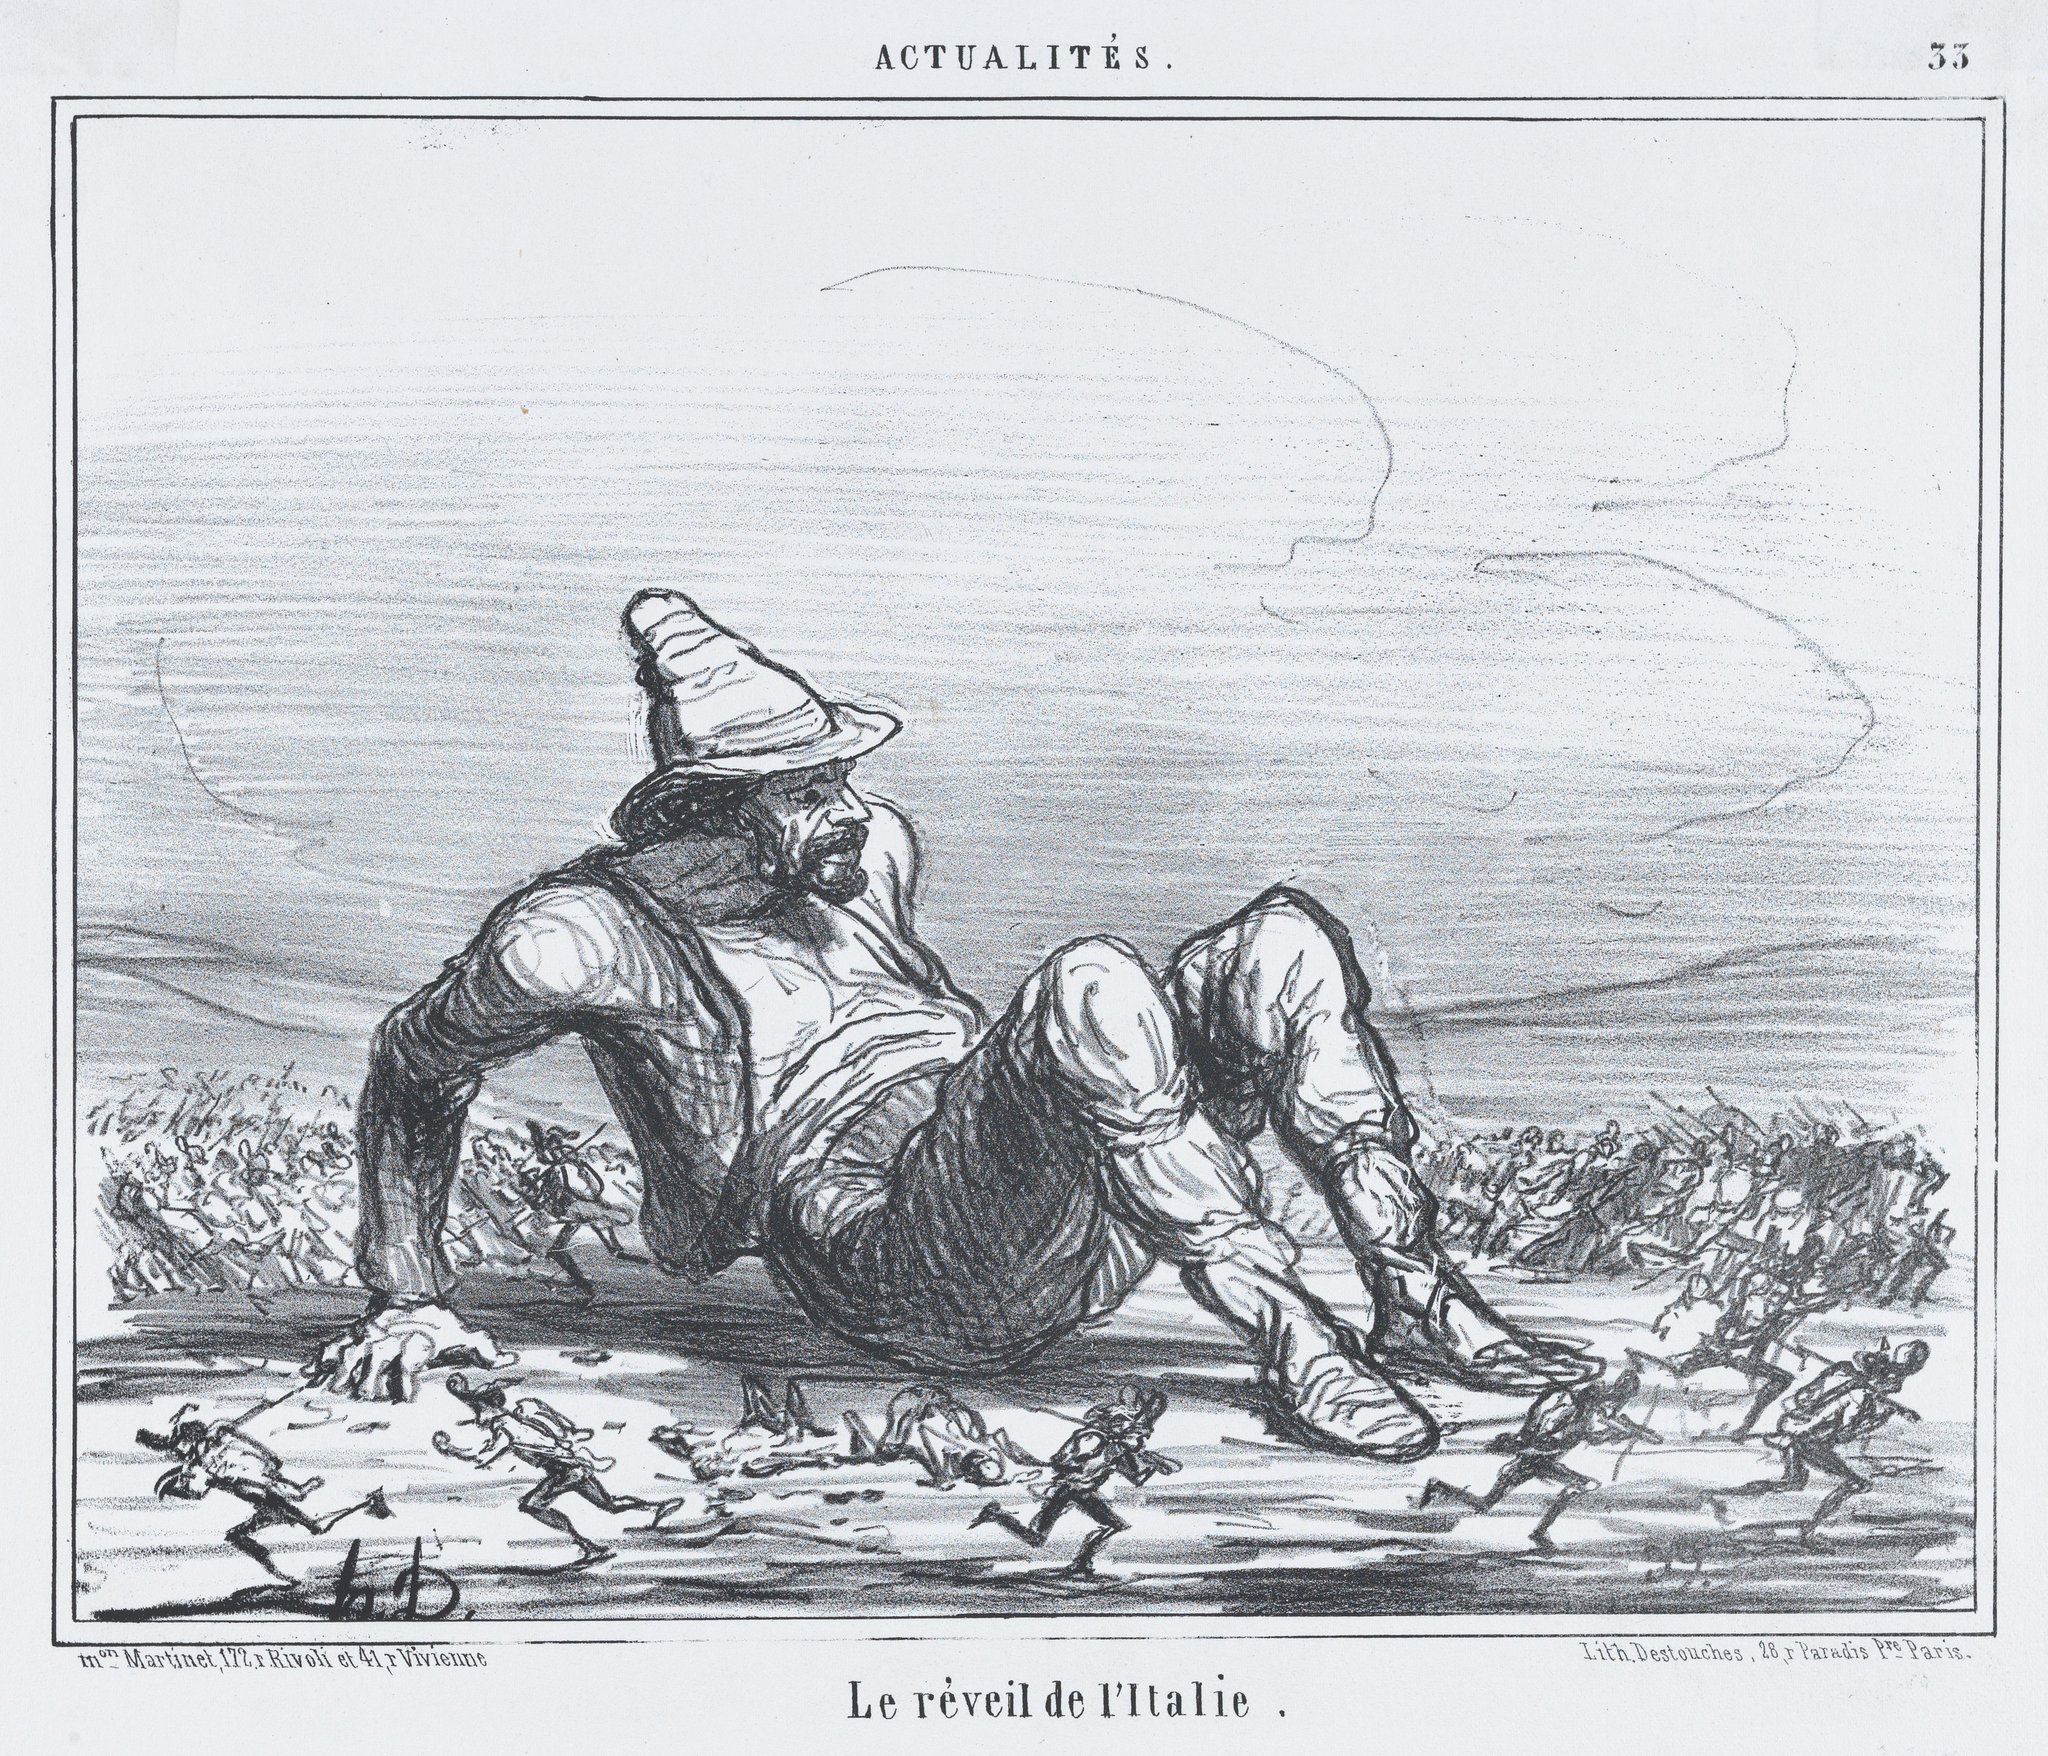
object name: print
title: Le réveil de l'Italie, from "Actualités"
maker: honoré daumier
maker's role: artist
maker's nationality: french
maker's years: 1808-1879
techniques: lithograph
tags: men